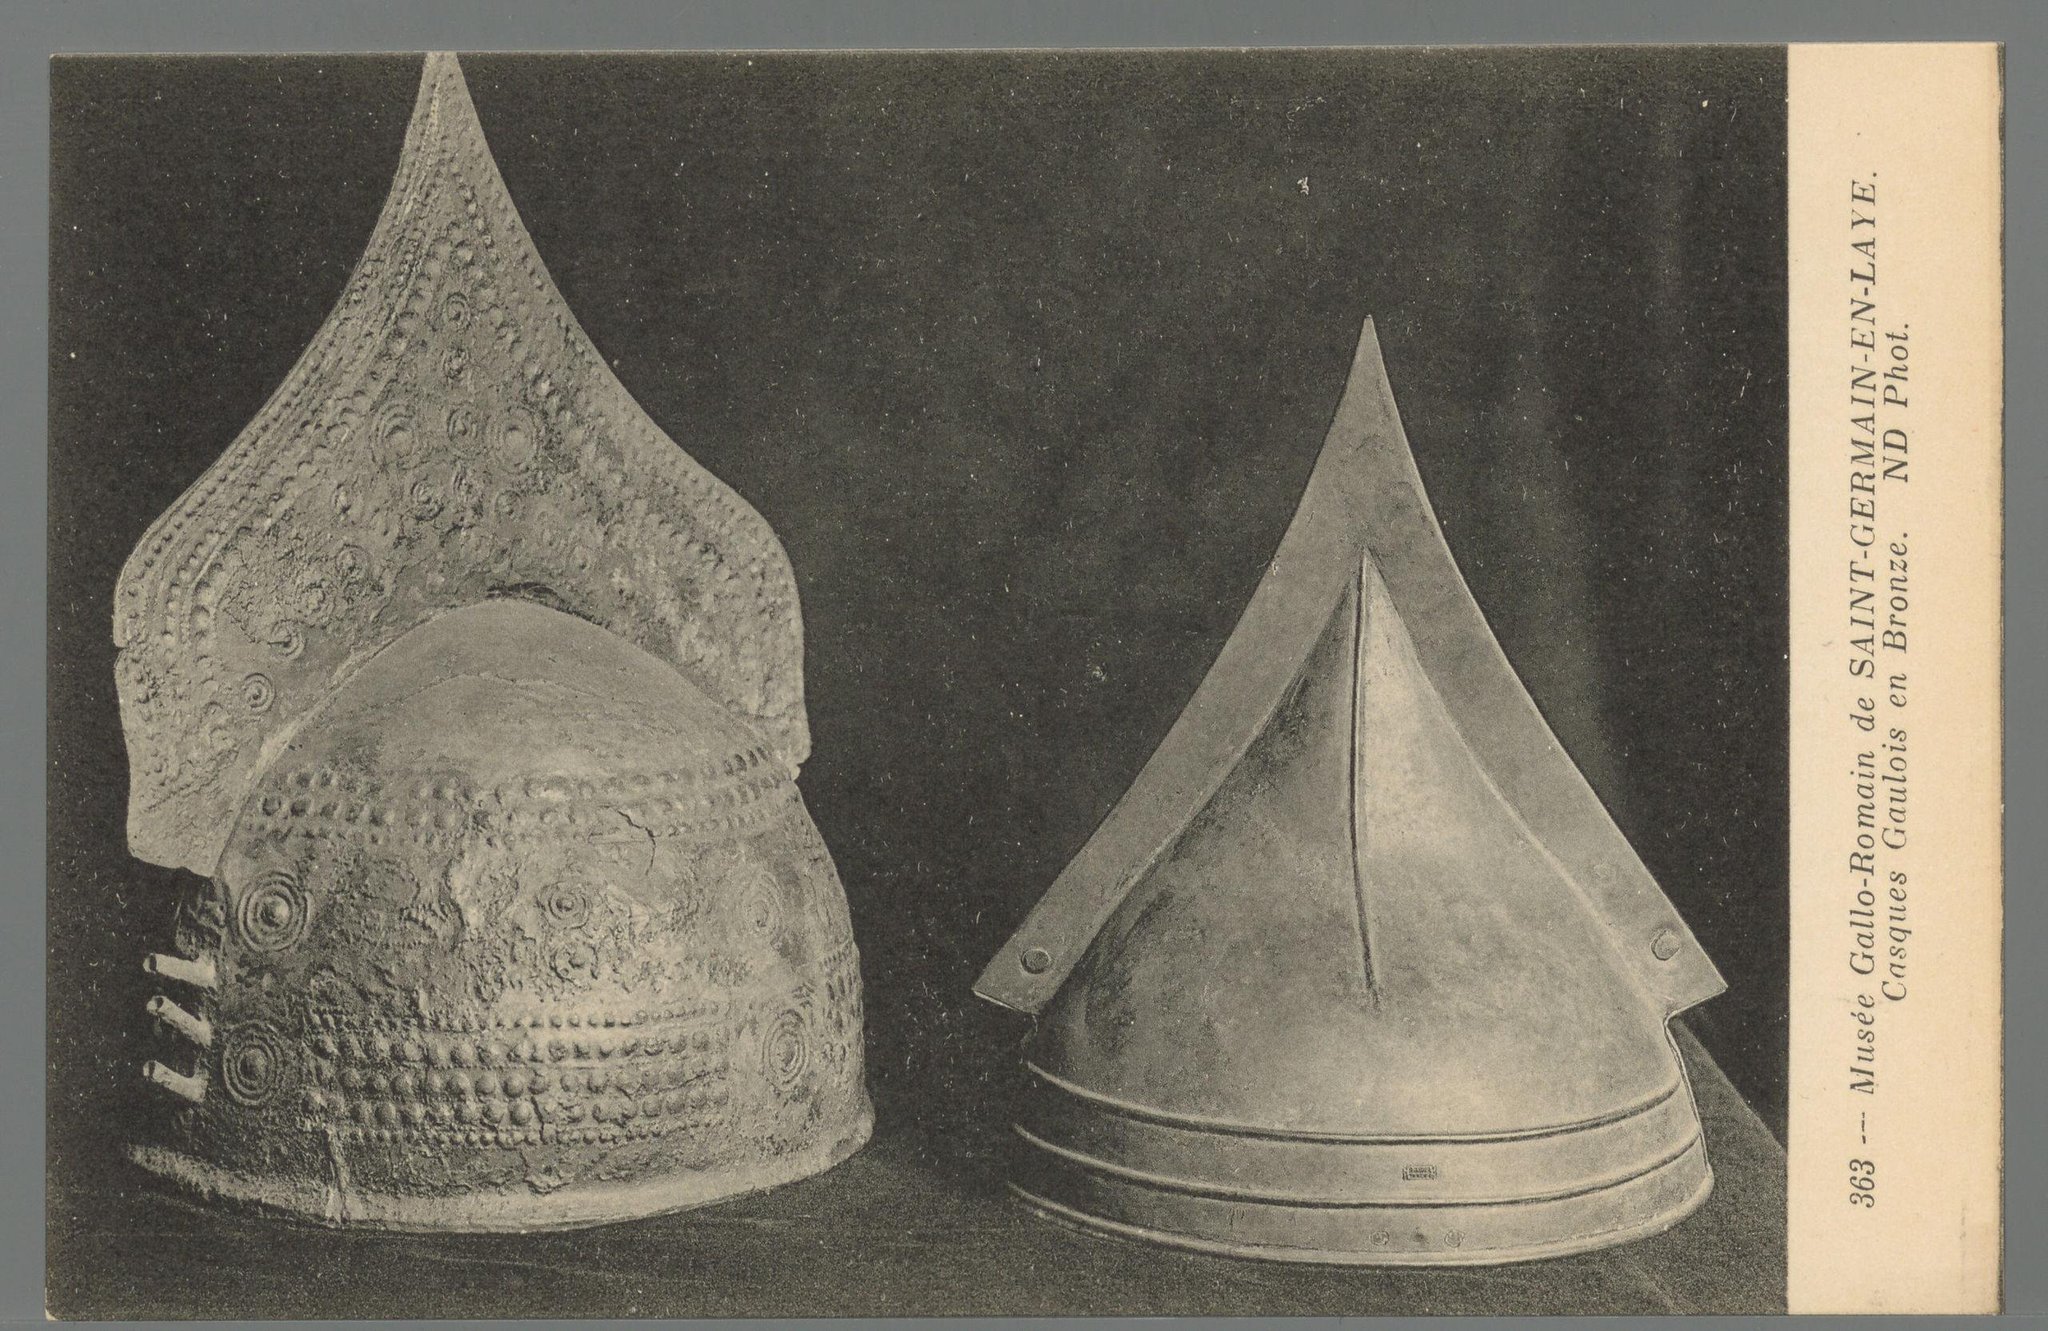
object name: photomechanical print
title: Musée Gallo-Romain de Saint-Germain-en-Laye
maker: Anonymous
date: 1903-1918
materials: cardboard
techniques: photograph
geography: paris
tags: helmet, permanent exhibition, museum